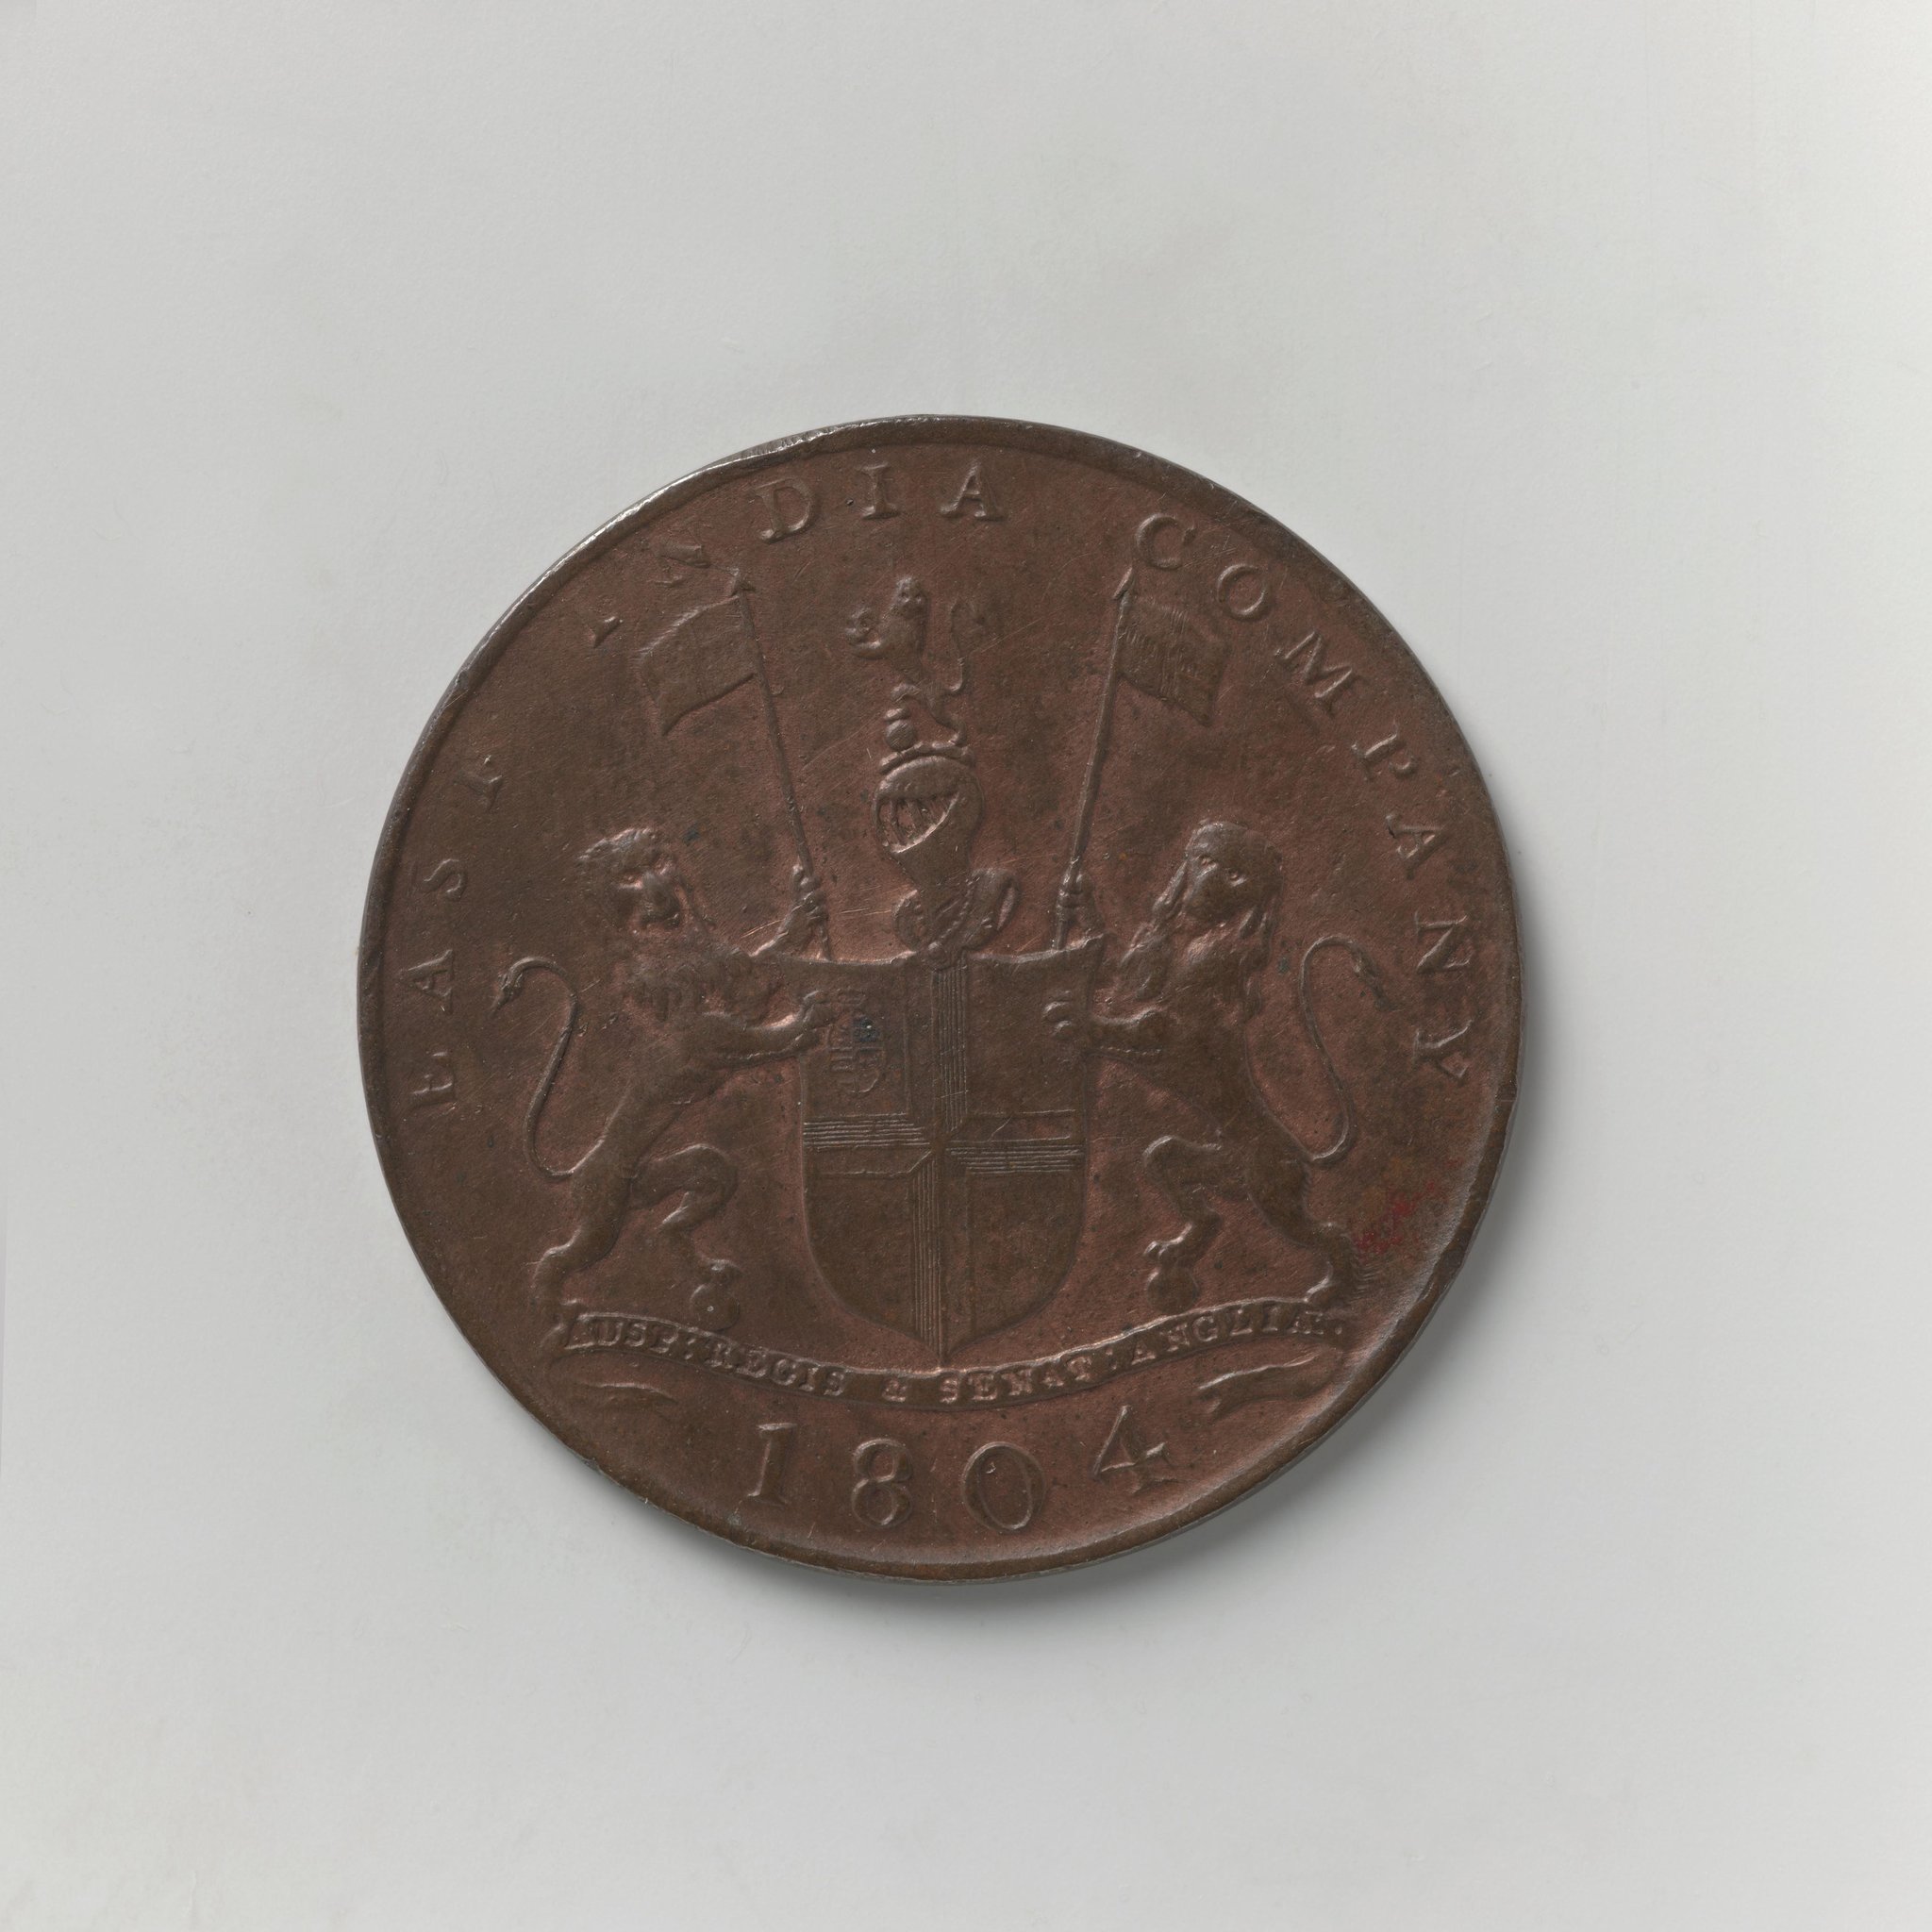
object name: coin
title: Singapore, 2 kepengs,1804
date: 1823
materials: copper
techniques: striking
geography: birmingham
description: Koperen munt. Voorzijde: door twee leeuwen gehouden wapenschild van de Engelse Oostindische Compagnie, waarboven aanduiding East India Company en waaronder wapenspreuk. Daaronder bevroren jaartal 1804. Keerzijde: op een regel in het Maleis waarde-aanduiding: doewa kepeng. Daarboven cijfer: 2 in Arabische cijfers en daaronder jaartal in Islamitische tijdsrekening en in Arabische cijfers. Gladde rand.